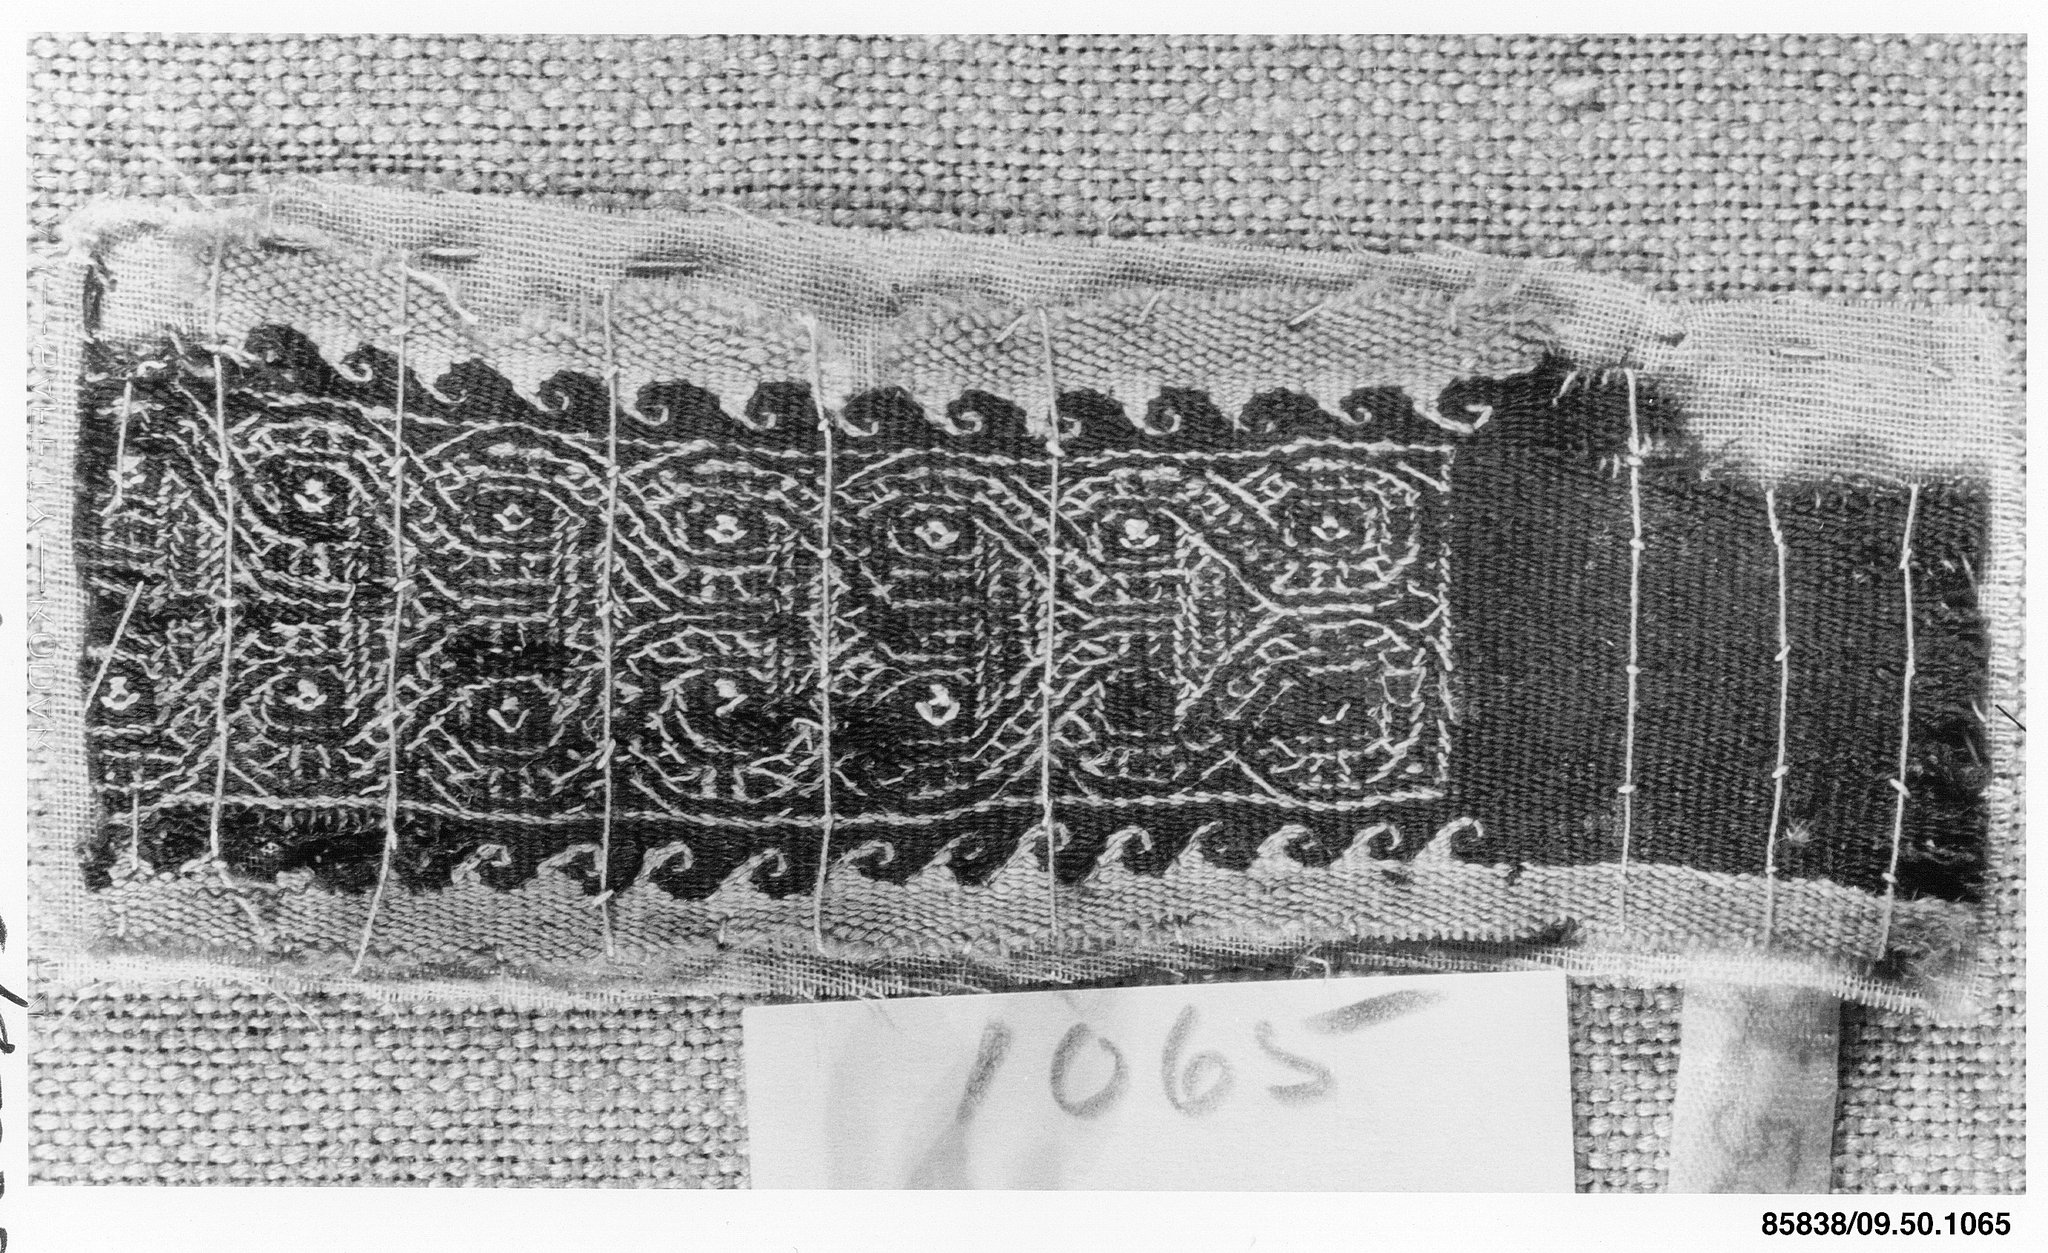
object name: band fragment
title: Fragment of a Band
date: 201-400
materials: linen, wool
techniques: weave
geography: egypt